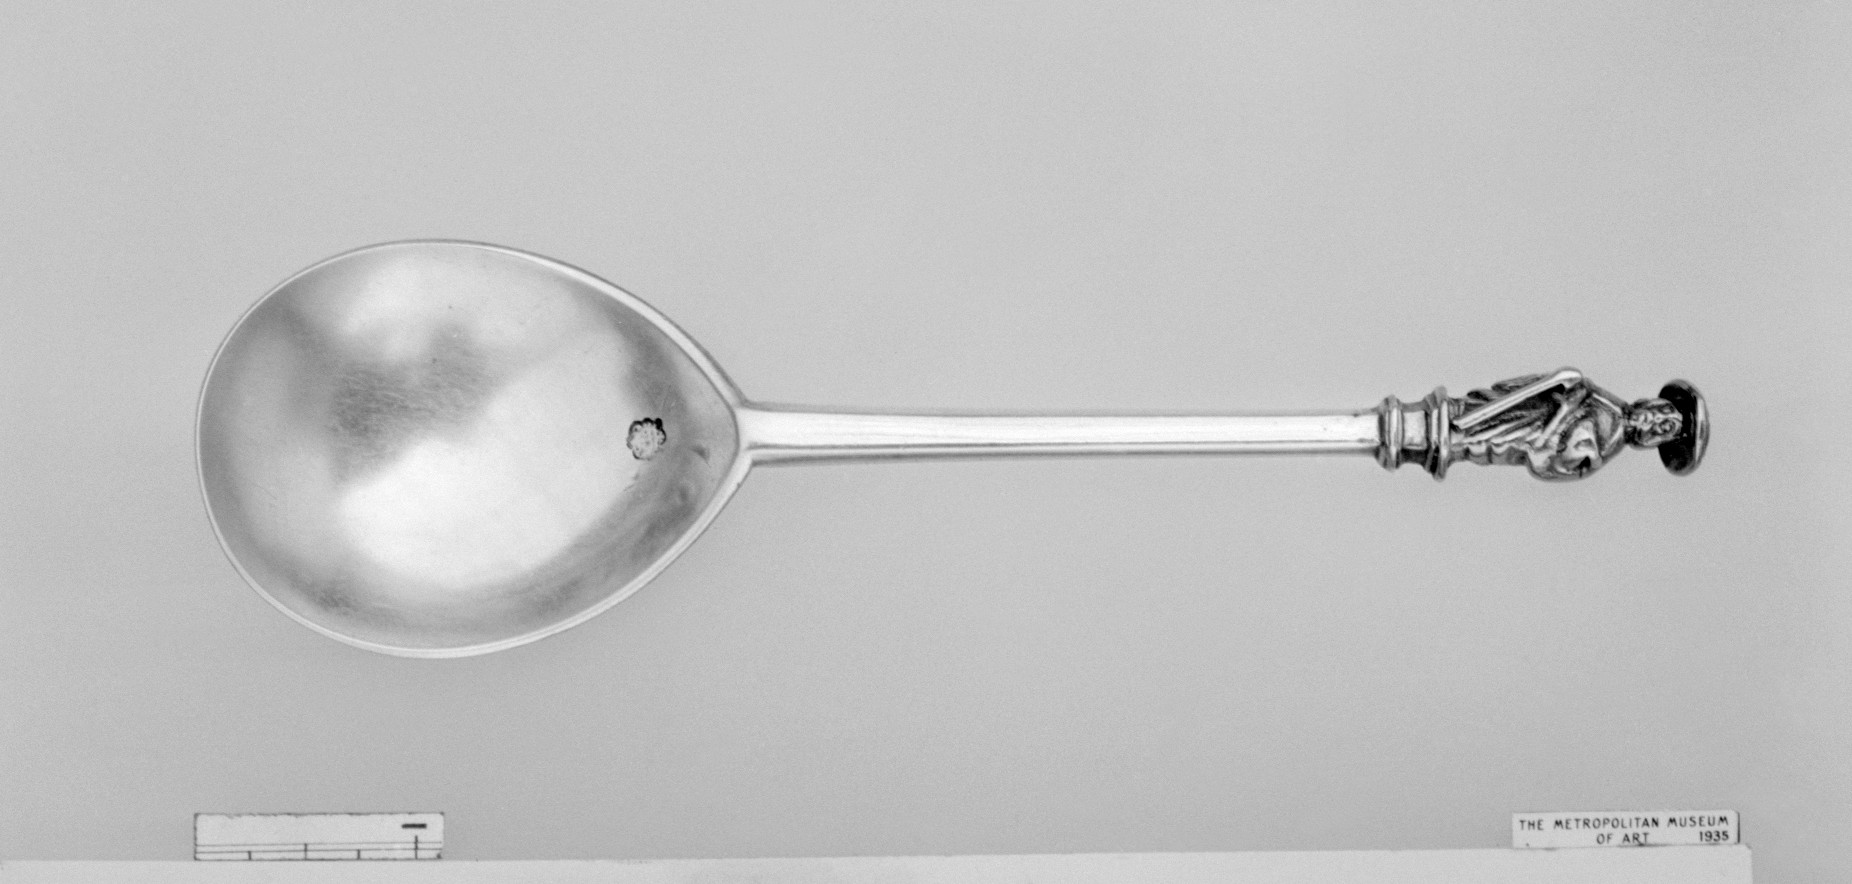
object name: apostle spoon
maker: john foxe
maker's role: maker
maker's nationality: british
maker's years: 1546-1597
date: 1565-1566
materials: gilt, silver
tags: apostles